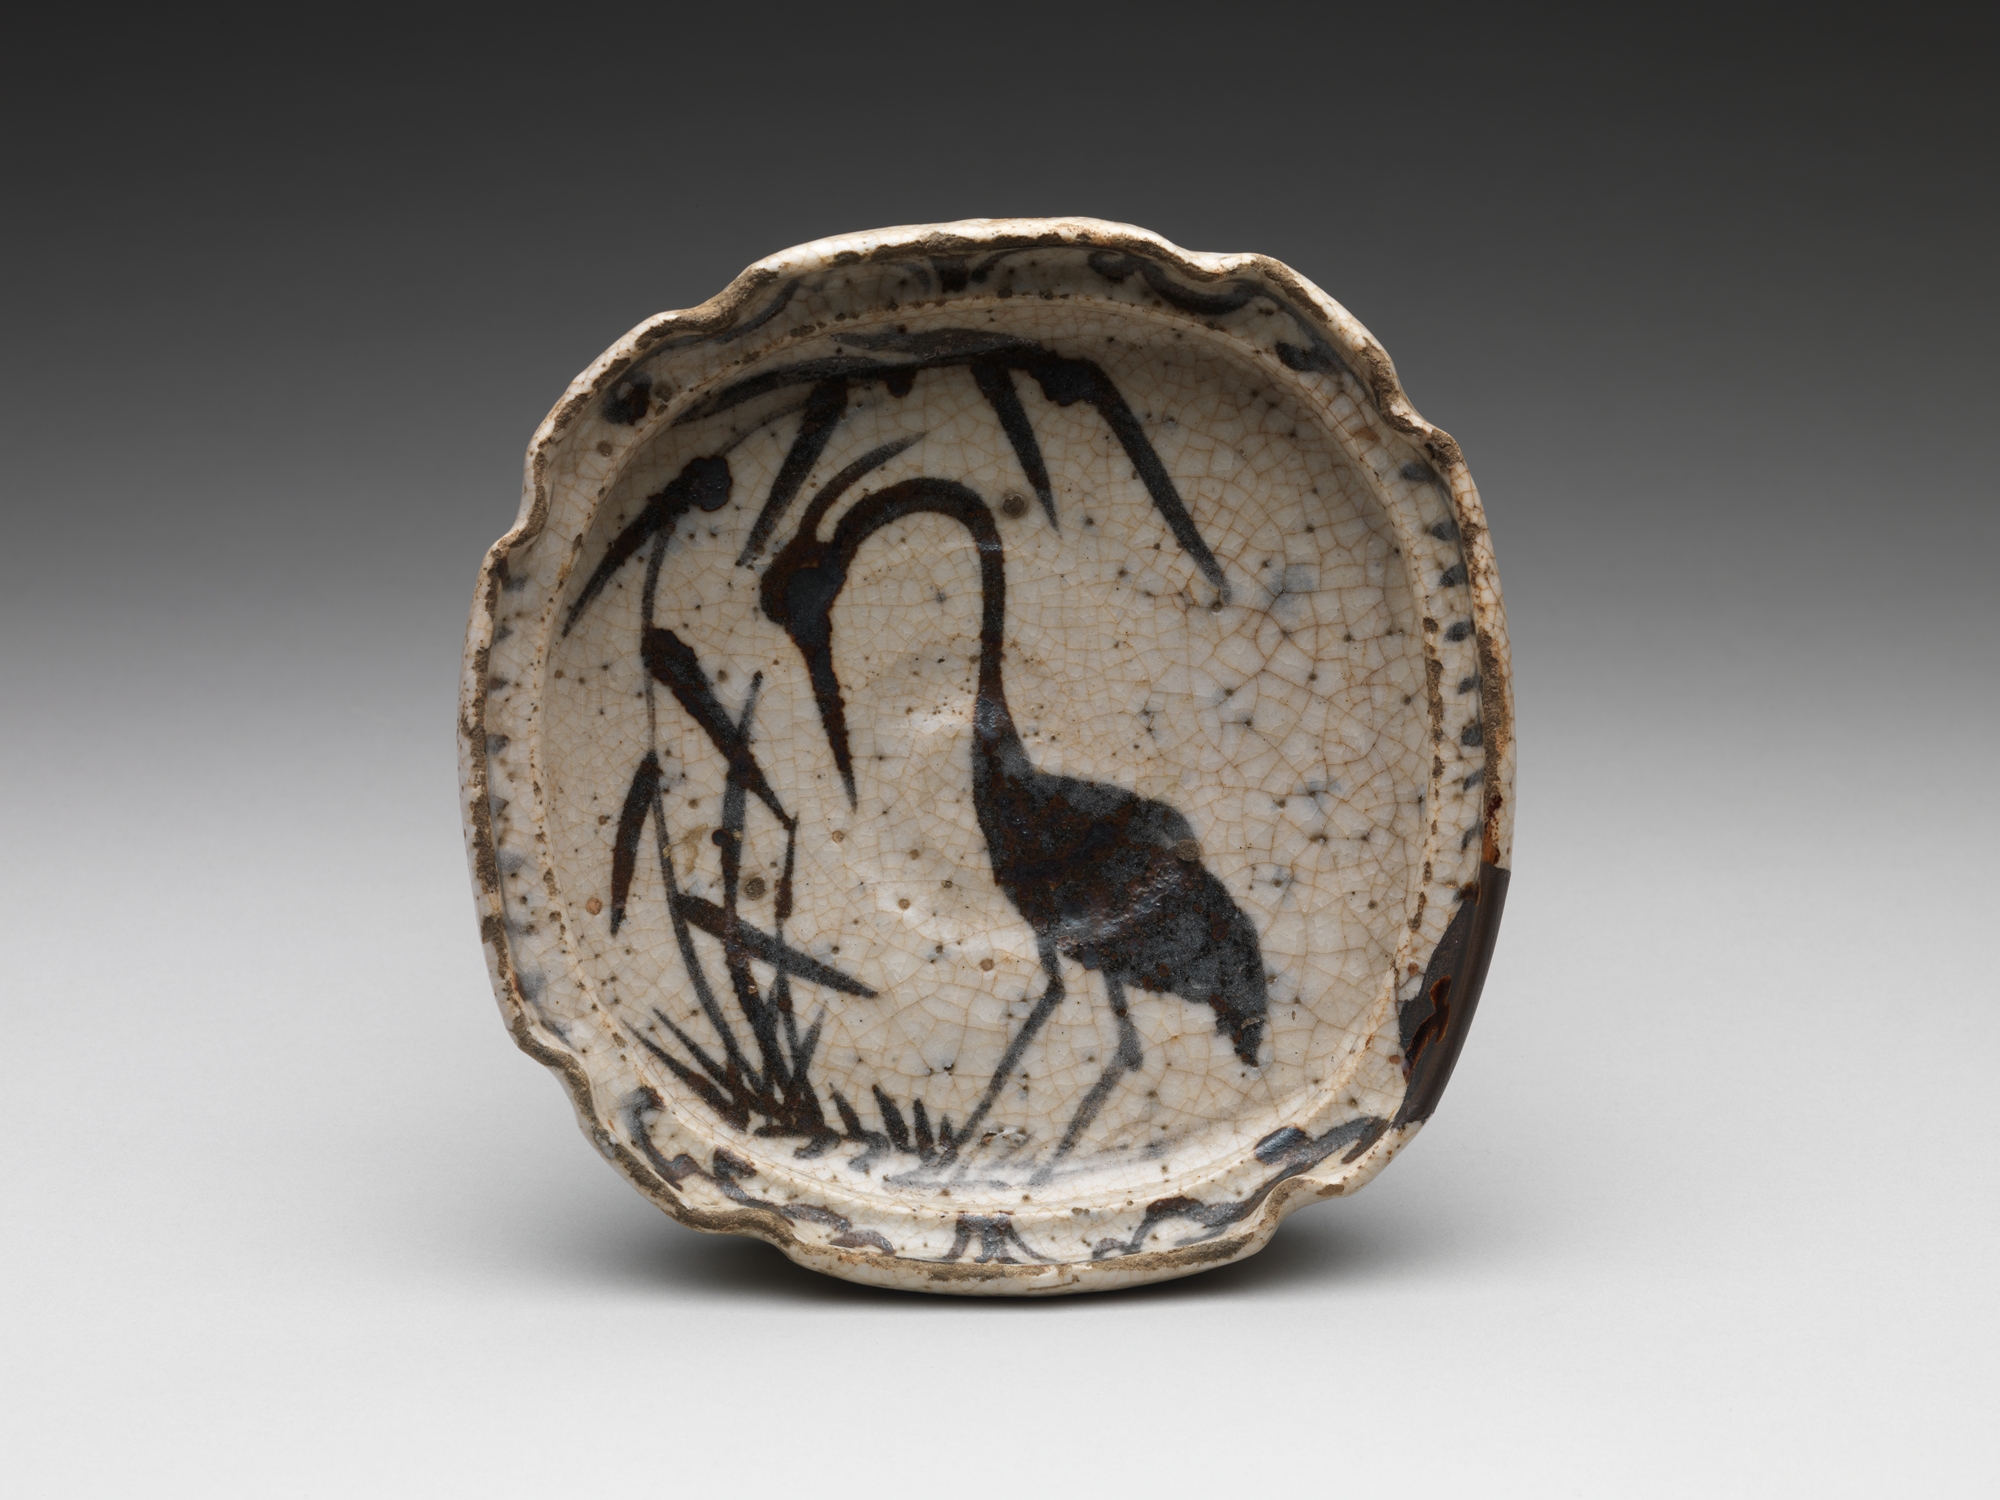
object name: bowl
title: Bowl with Heron in Reeds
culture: japanese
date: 1567-1600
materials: iron, stoneware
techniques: underglaze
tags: birds